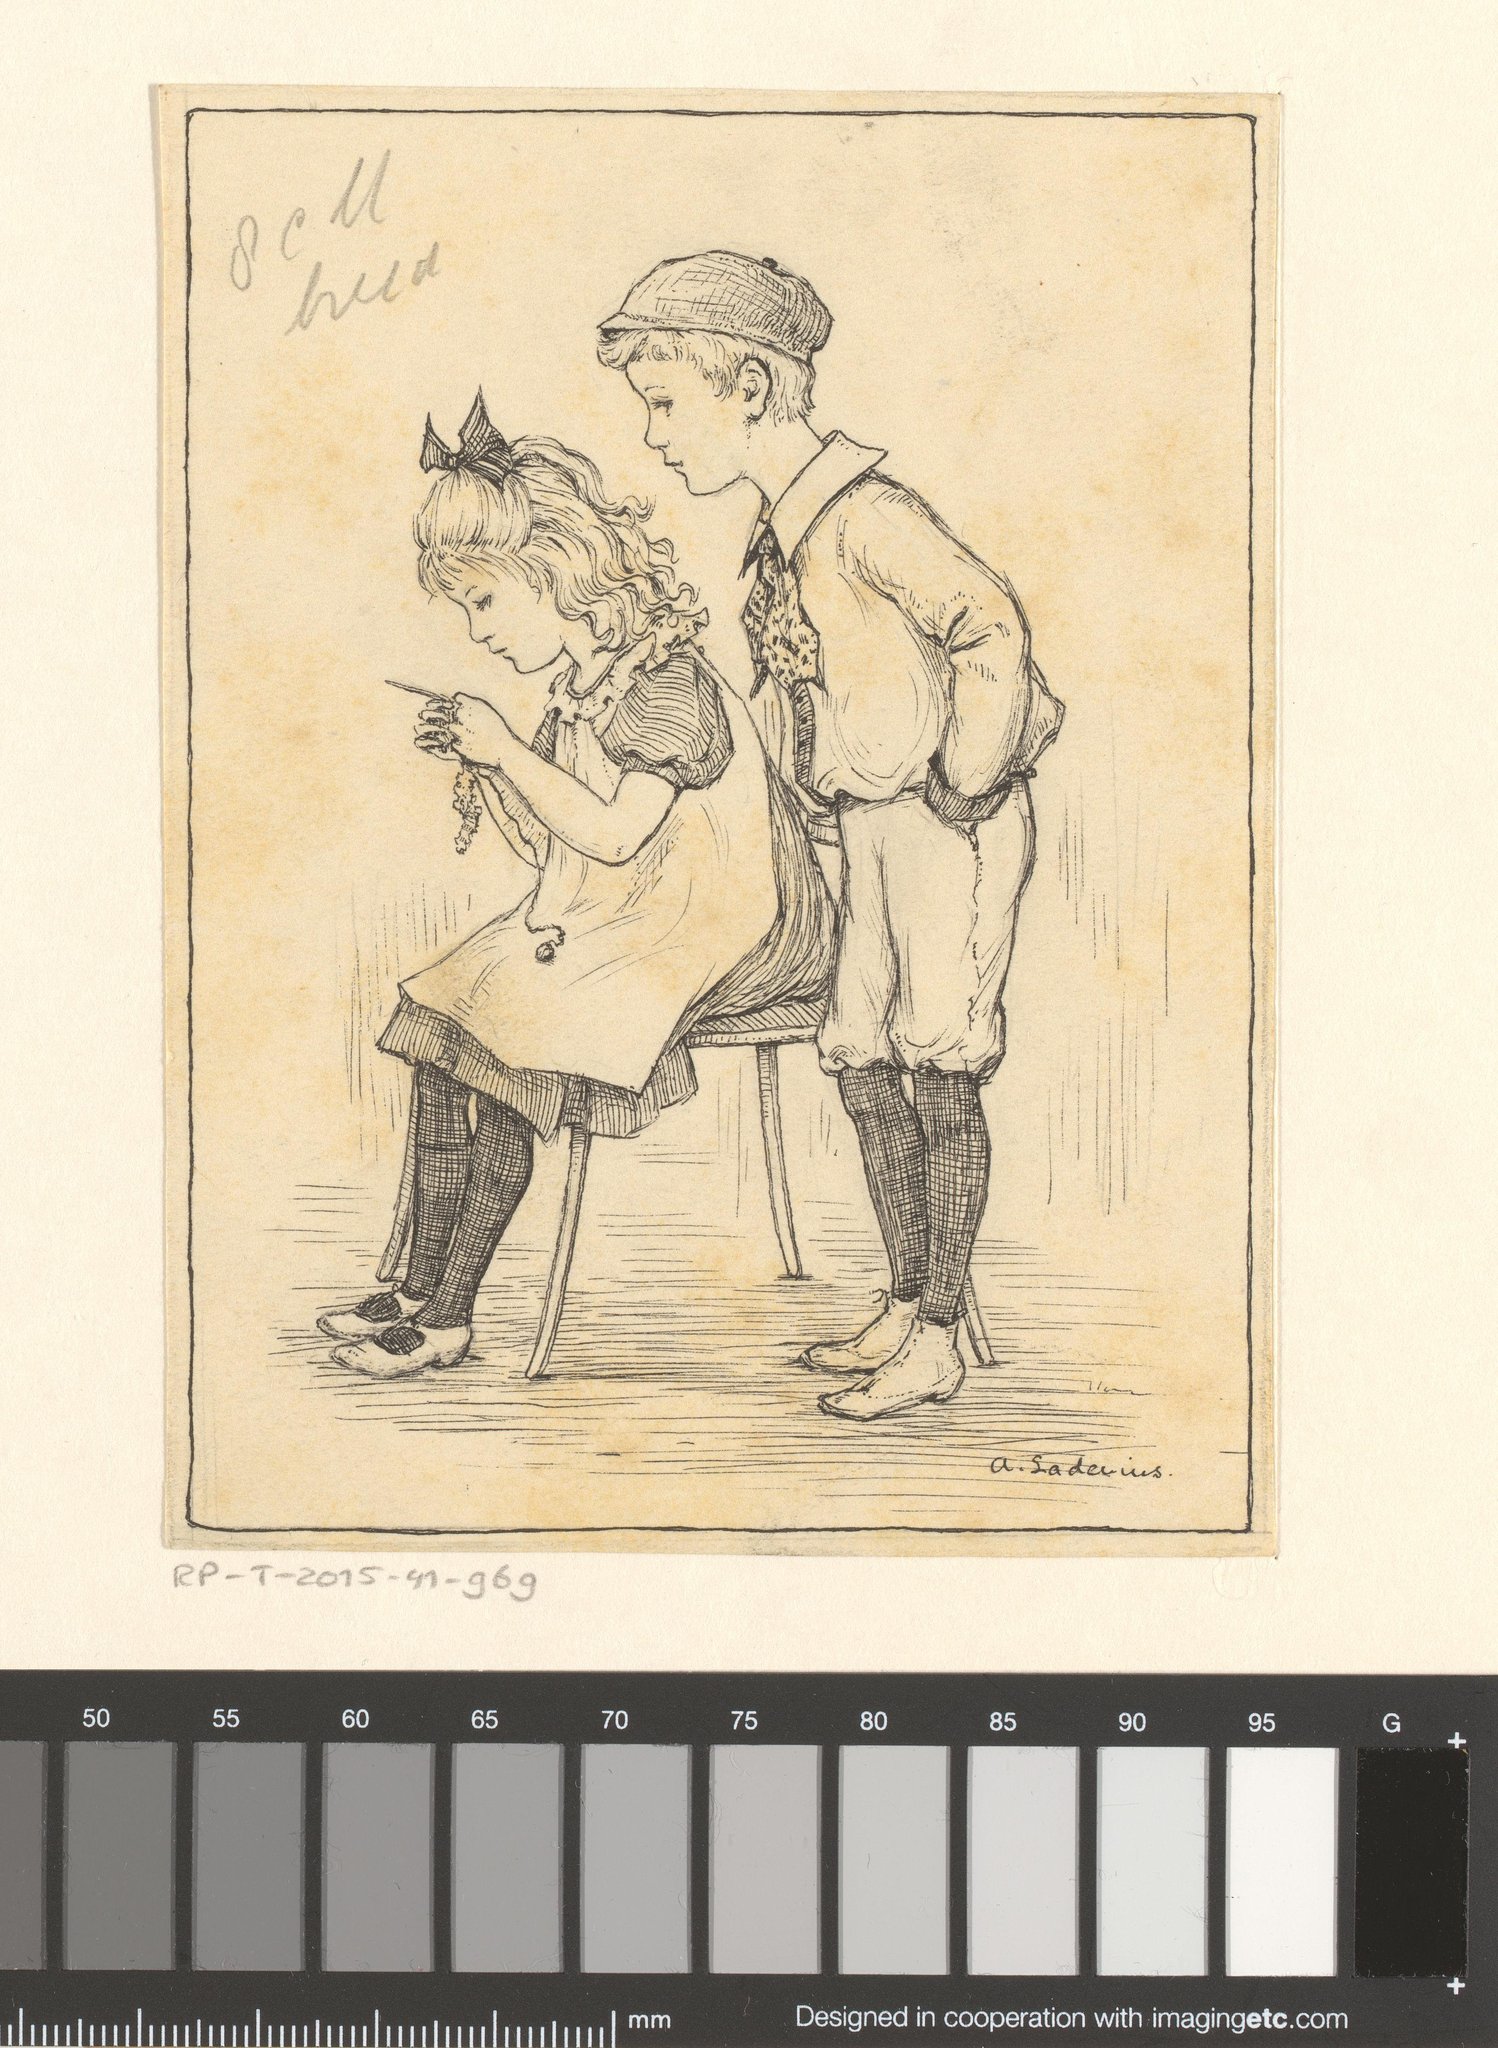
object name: drawing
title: Handwerkend meisje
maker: adri ladenius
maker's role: draughtsman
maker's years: 1883-1953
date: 1893-1953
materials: ink, paper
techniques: pen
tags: manufacturing with yarn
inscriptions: collector's mark: Lugt 2228, number: ‘1’, :, signature: ‘A. Ladenius.’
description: Een meisje zit op een stoel te handwerken. Een jongen kijkt mee over haar schouder.